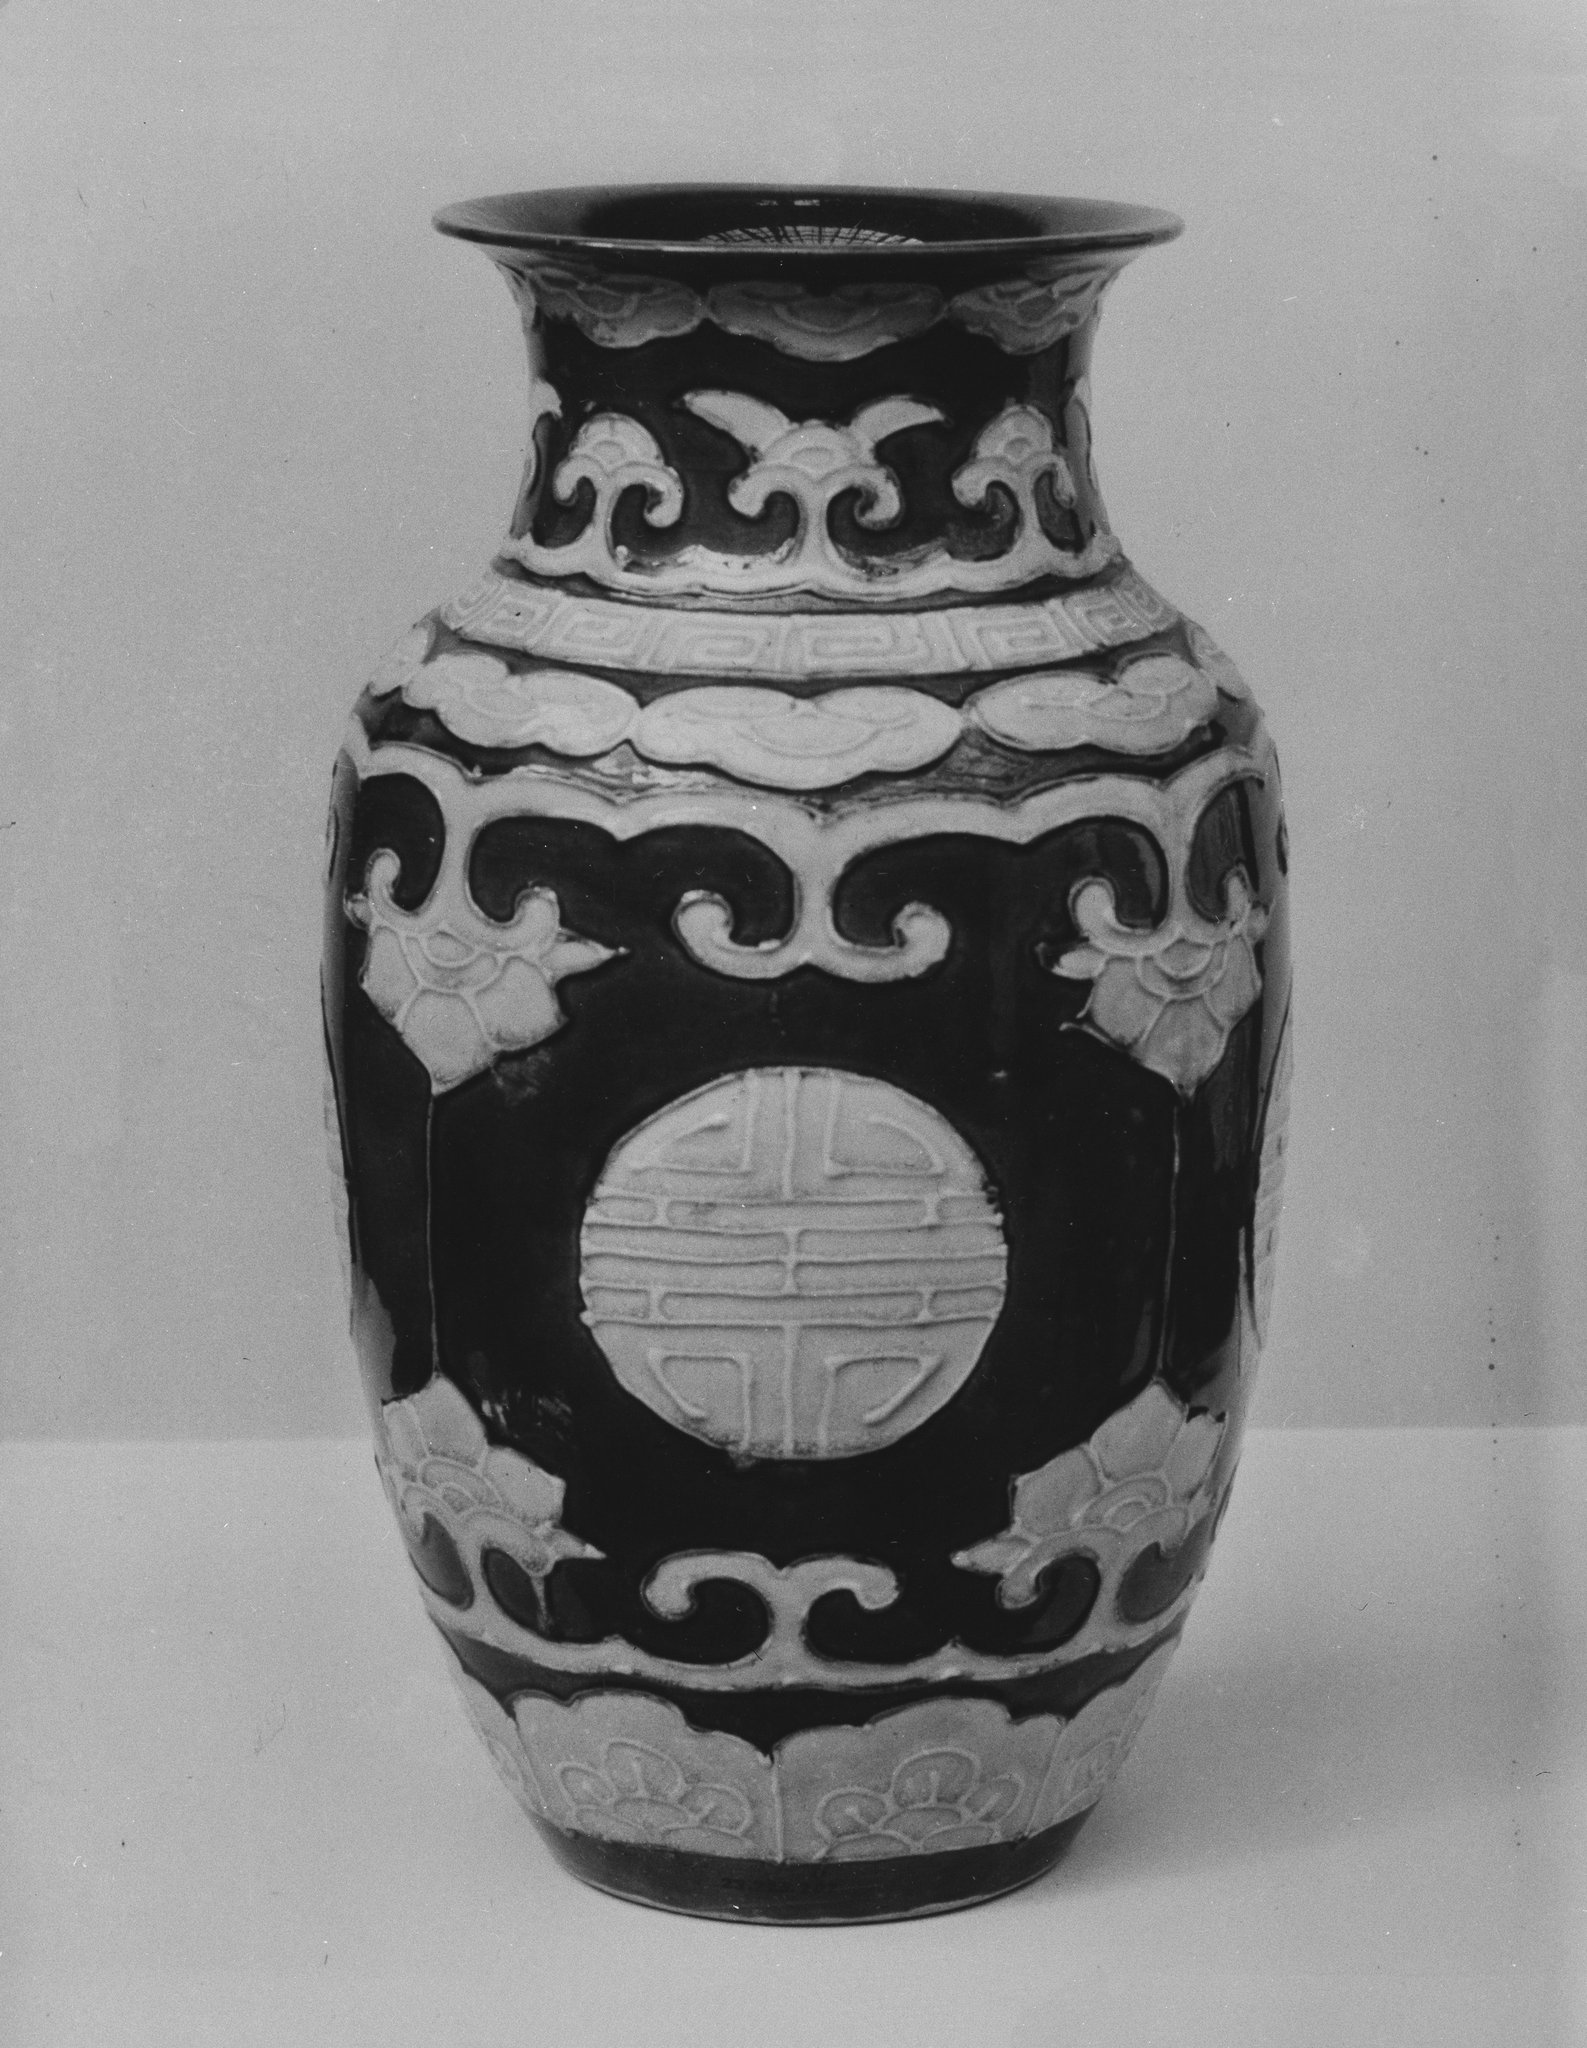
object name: vase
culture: japanese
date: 1820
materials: stoneware